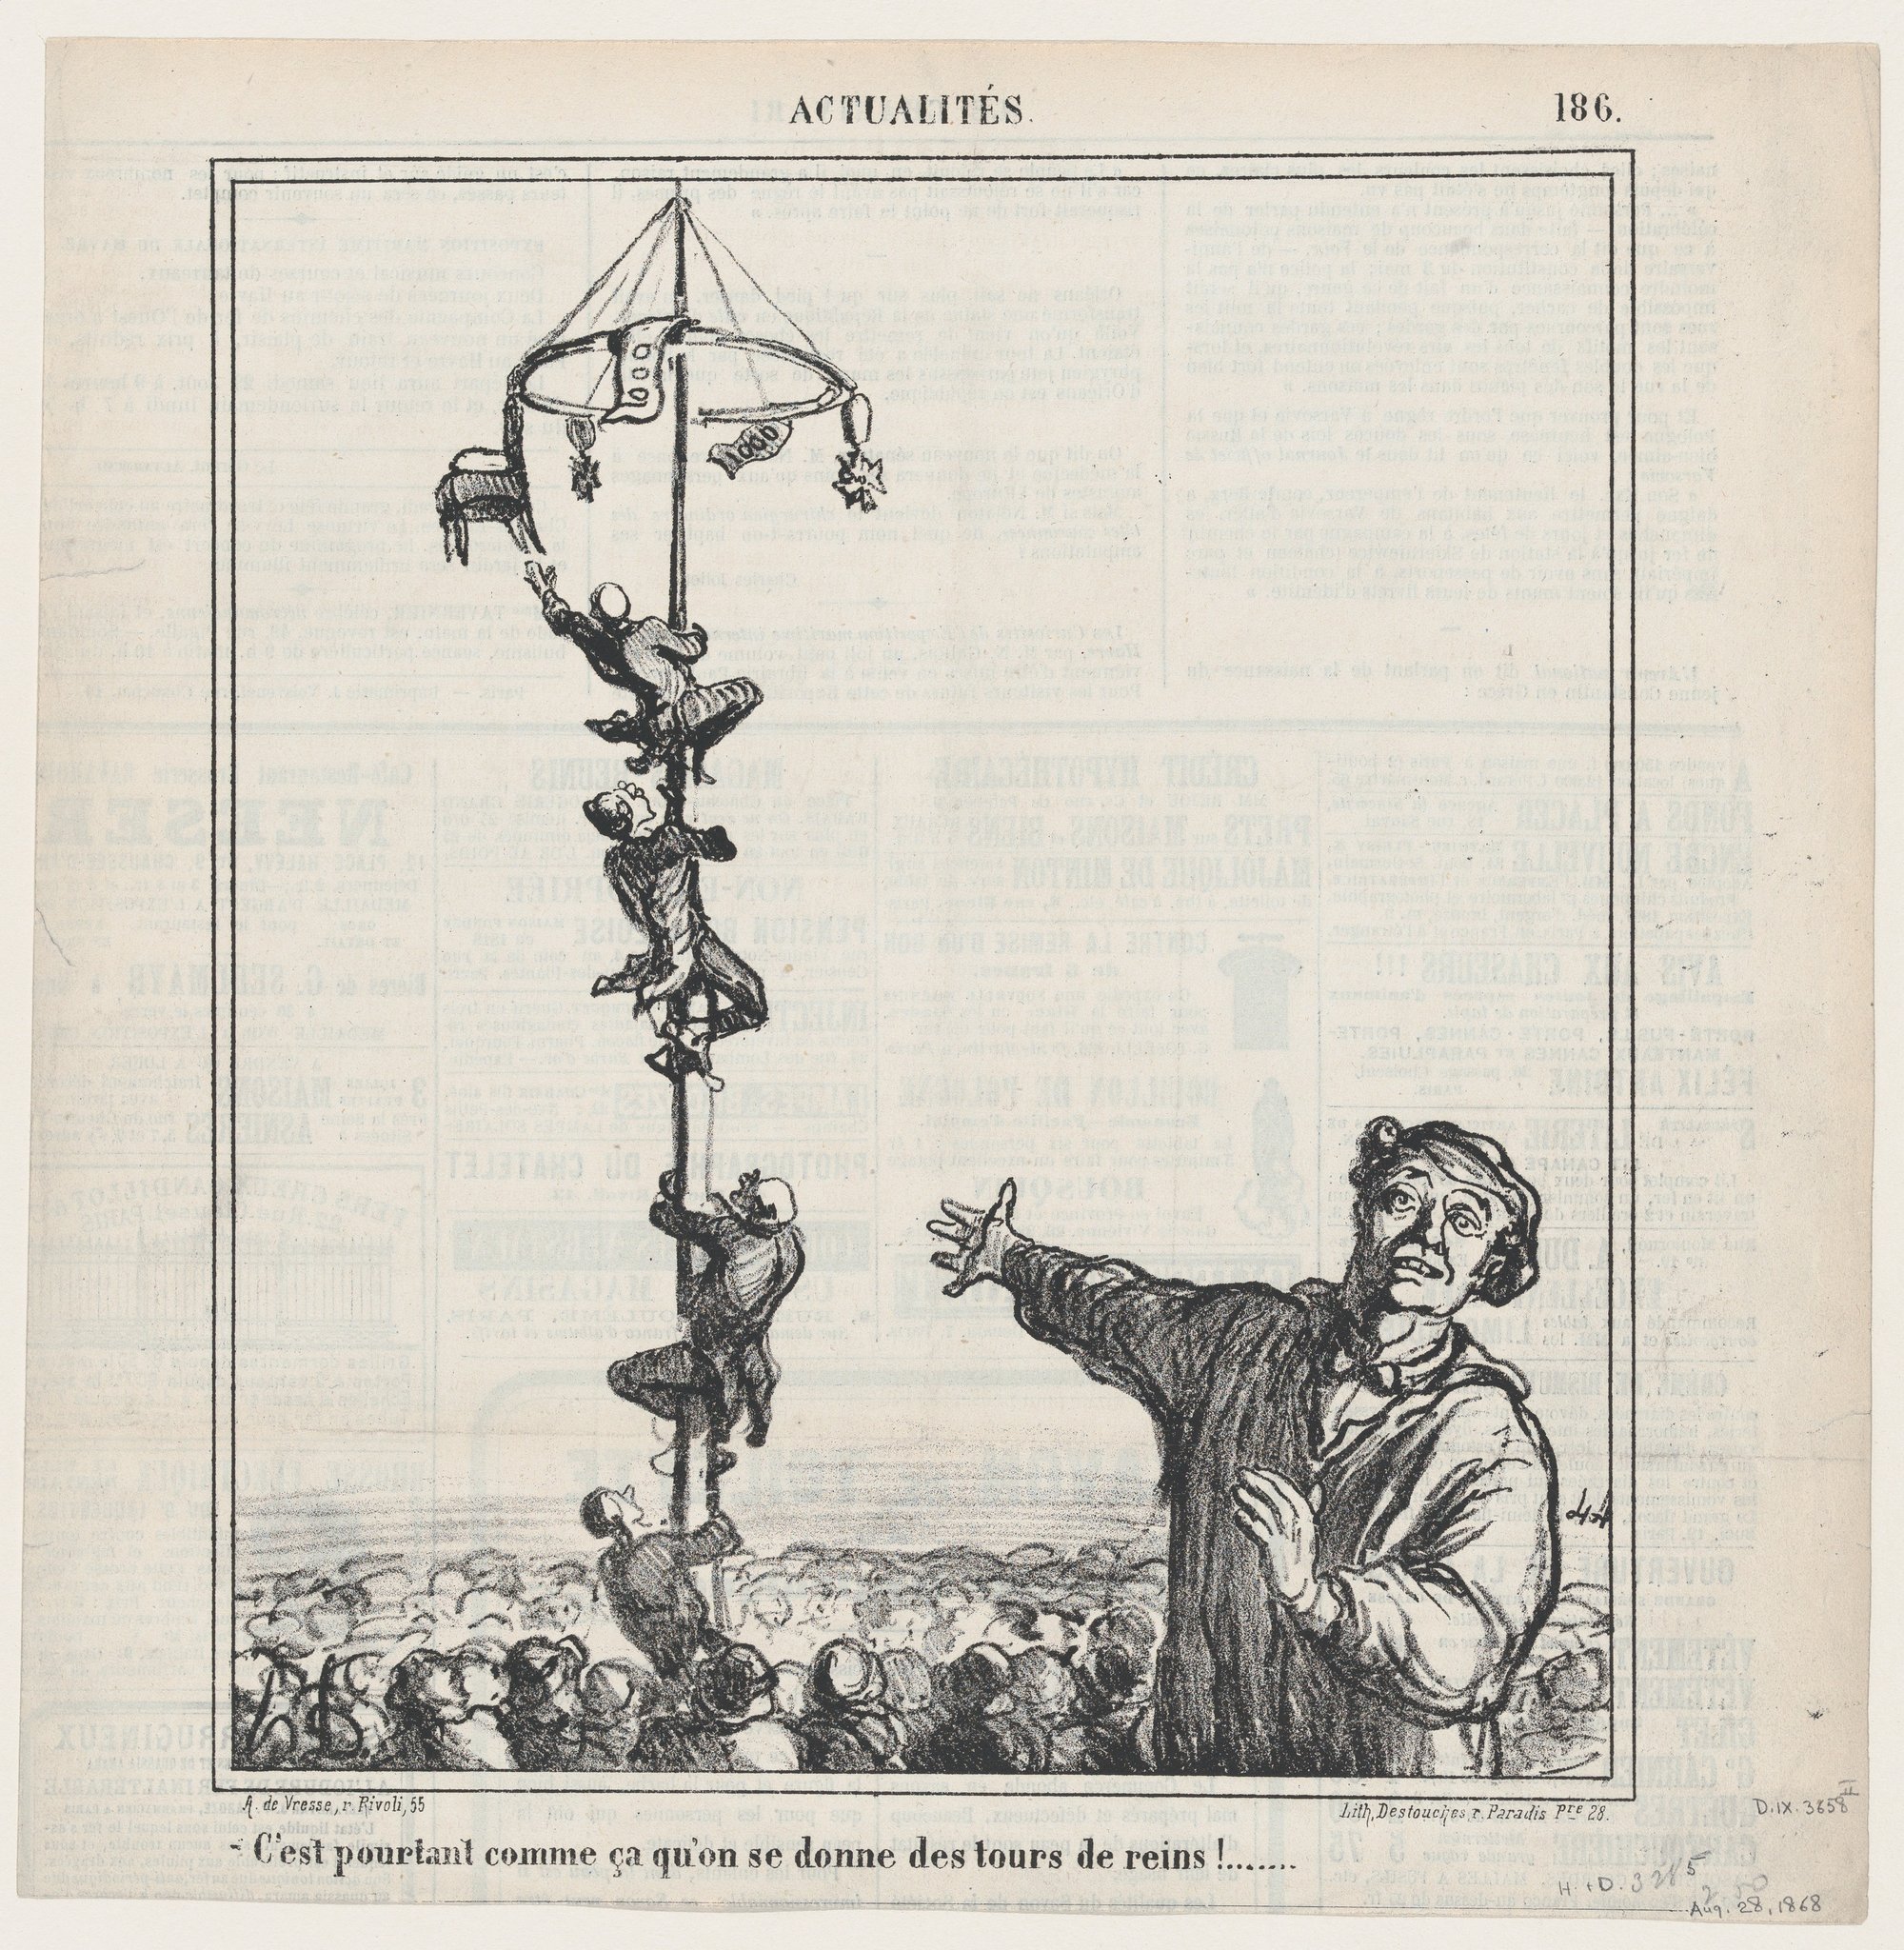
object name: print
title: This is just the way to strain your back, from "News of the day"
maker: honoré daumier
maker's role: artist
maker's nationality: french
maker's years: 1808-1879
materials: paper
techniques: lithograph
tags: men,crowd